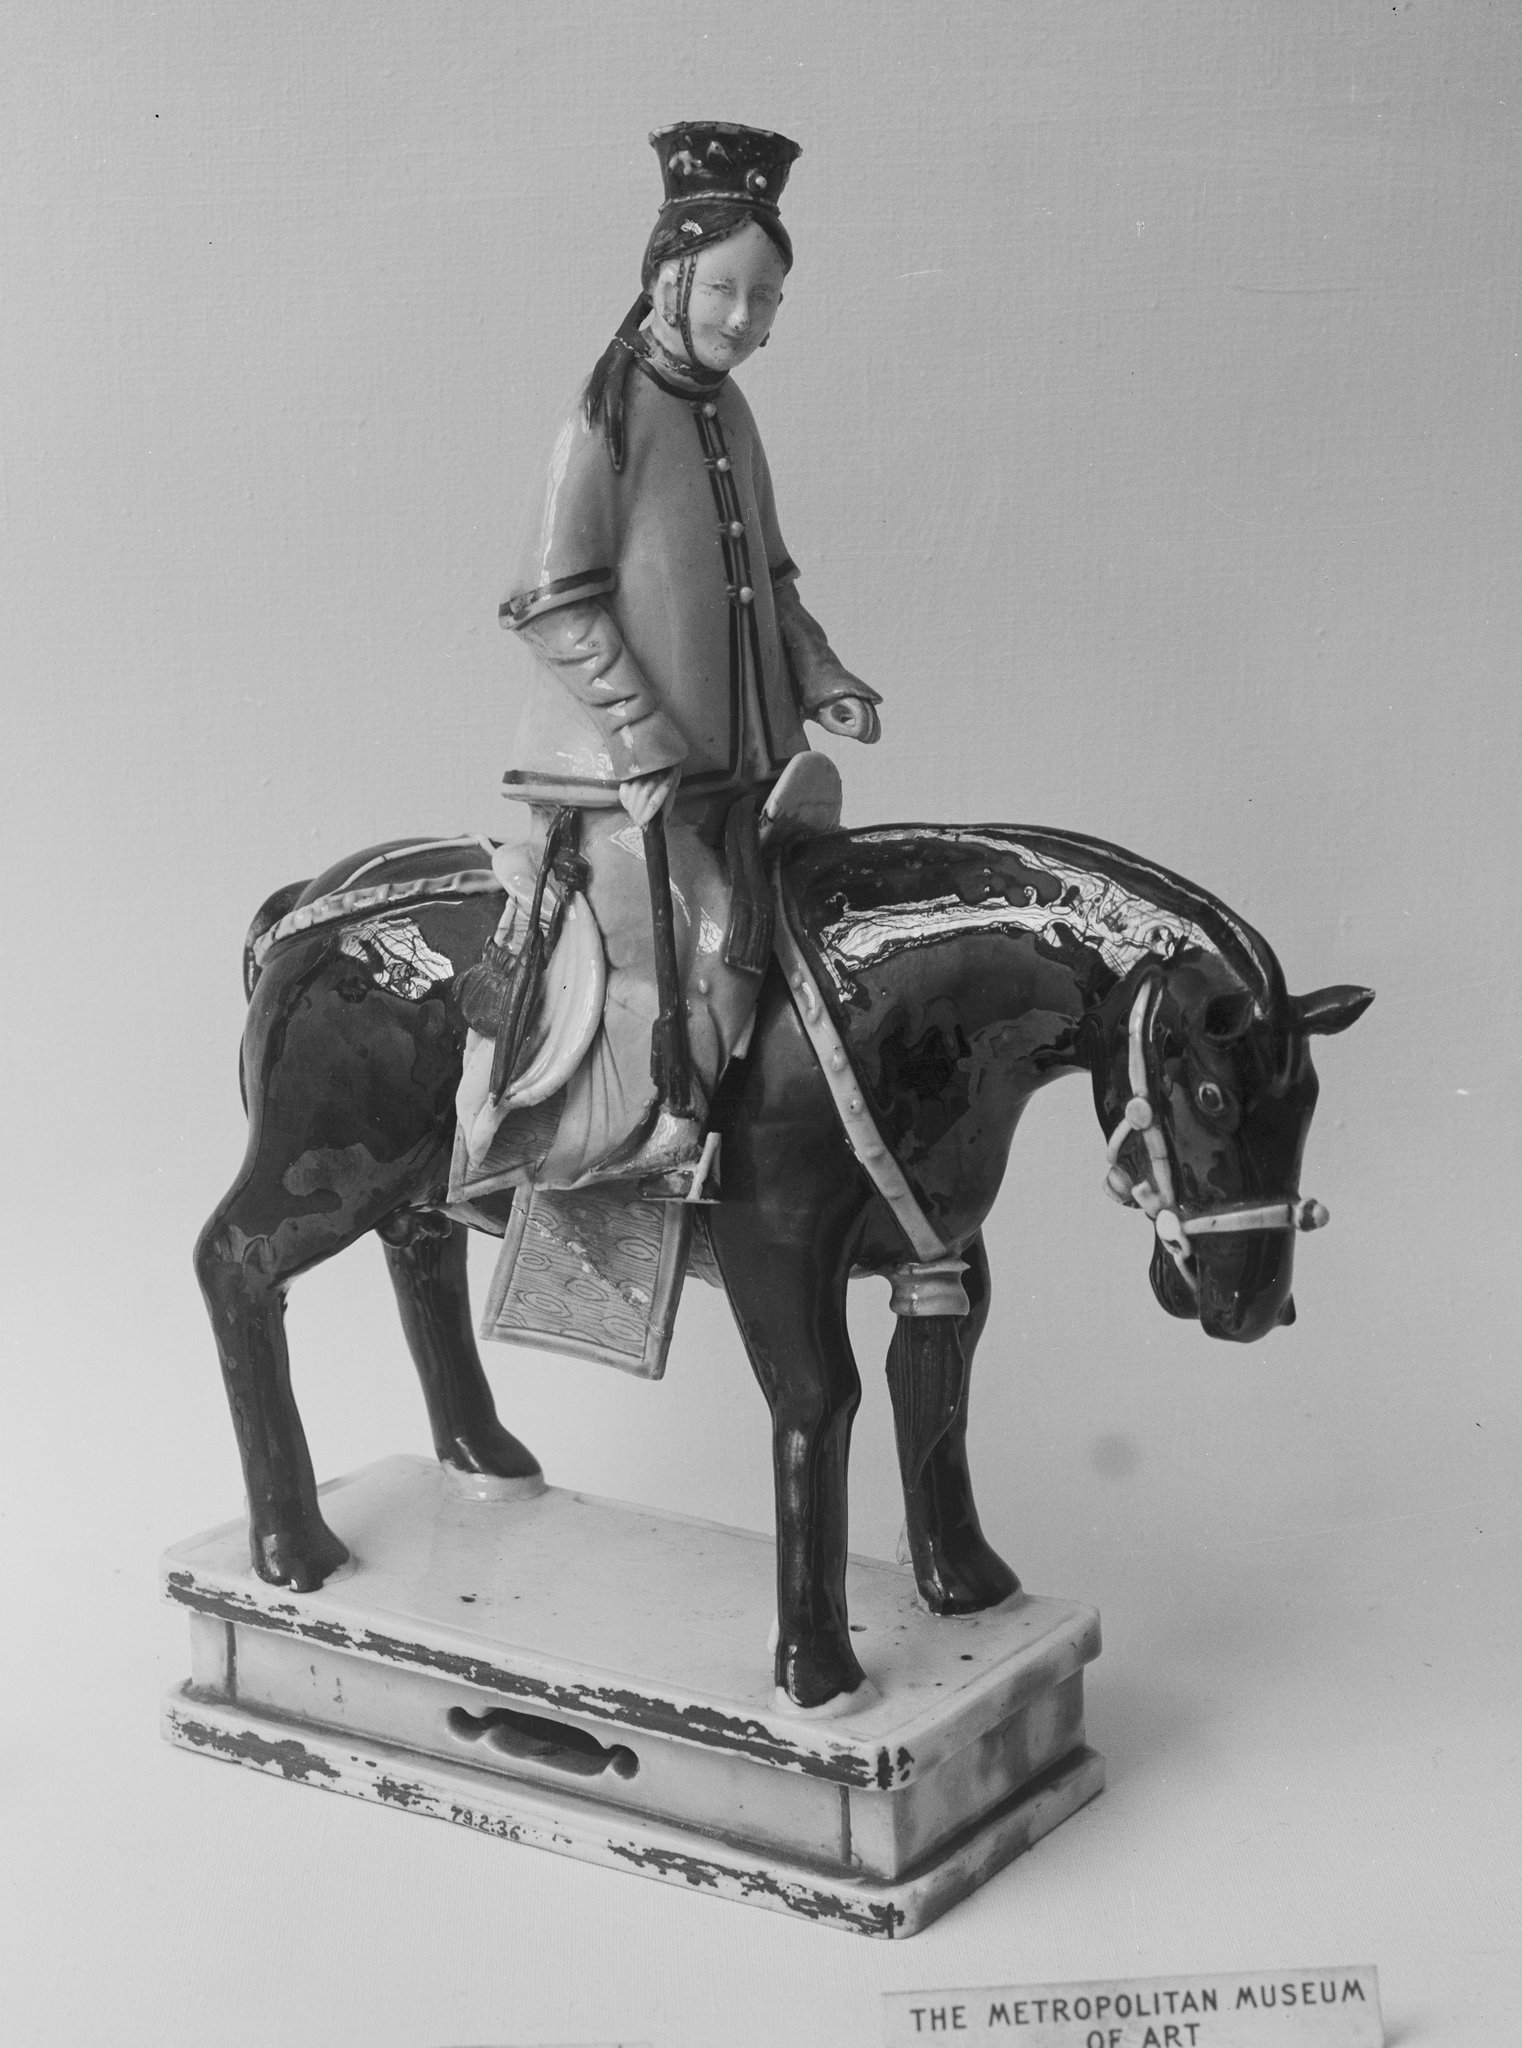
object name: figure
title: Figure of Lady on Horseback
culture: chinese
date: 1667-1733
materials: glaze, porcelain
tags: women,horses